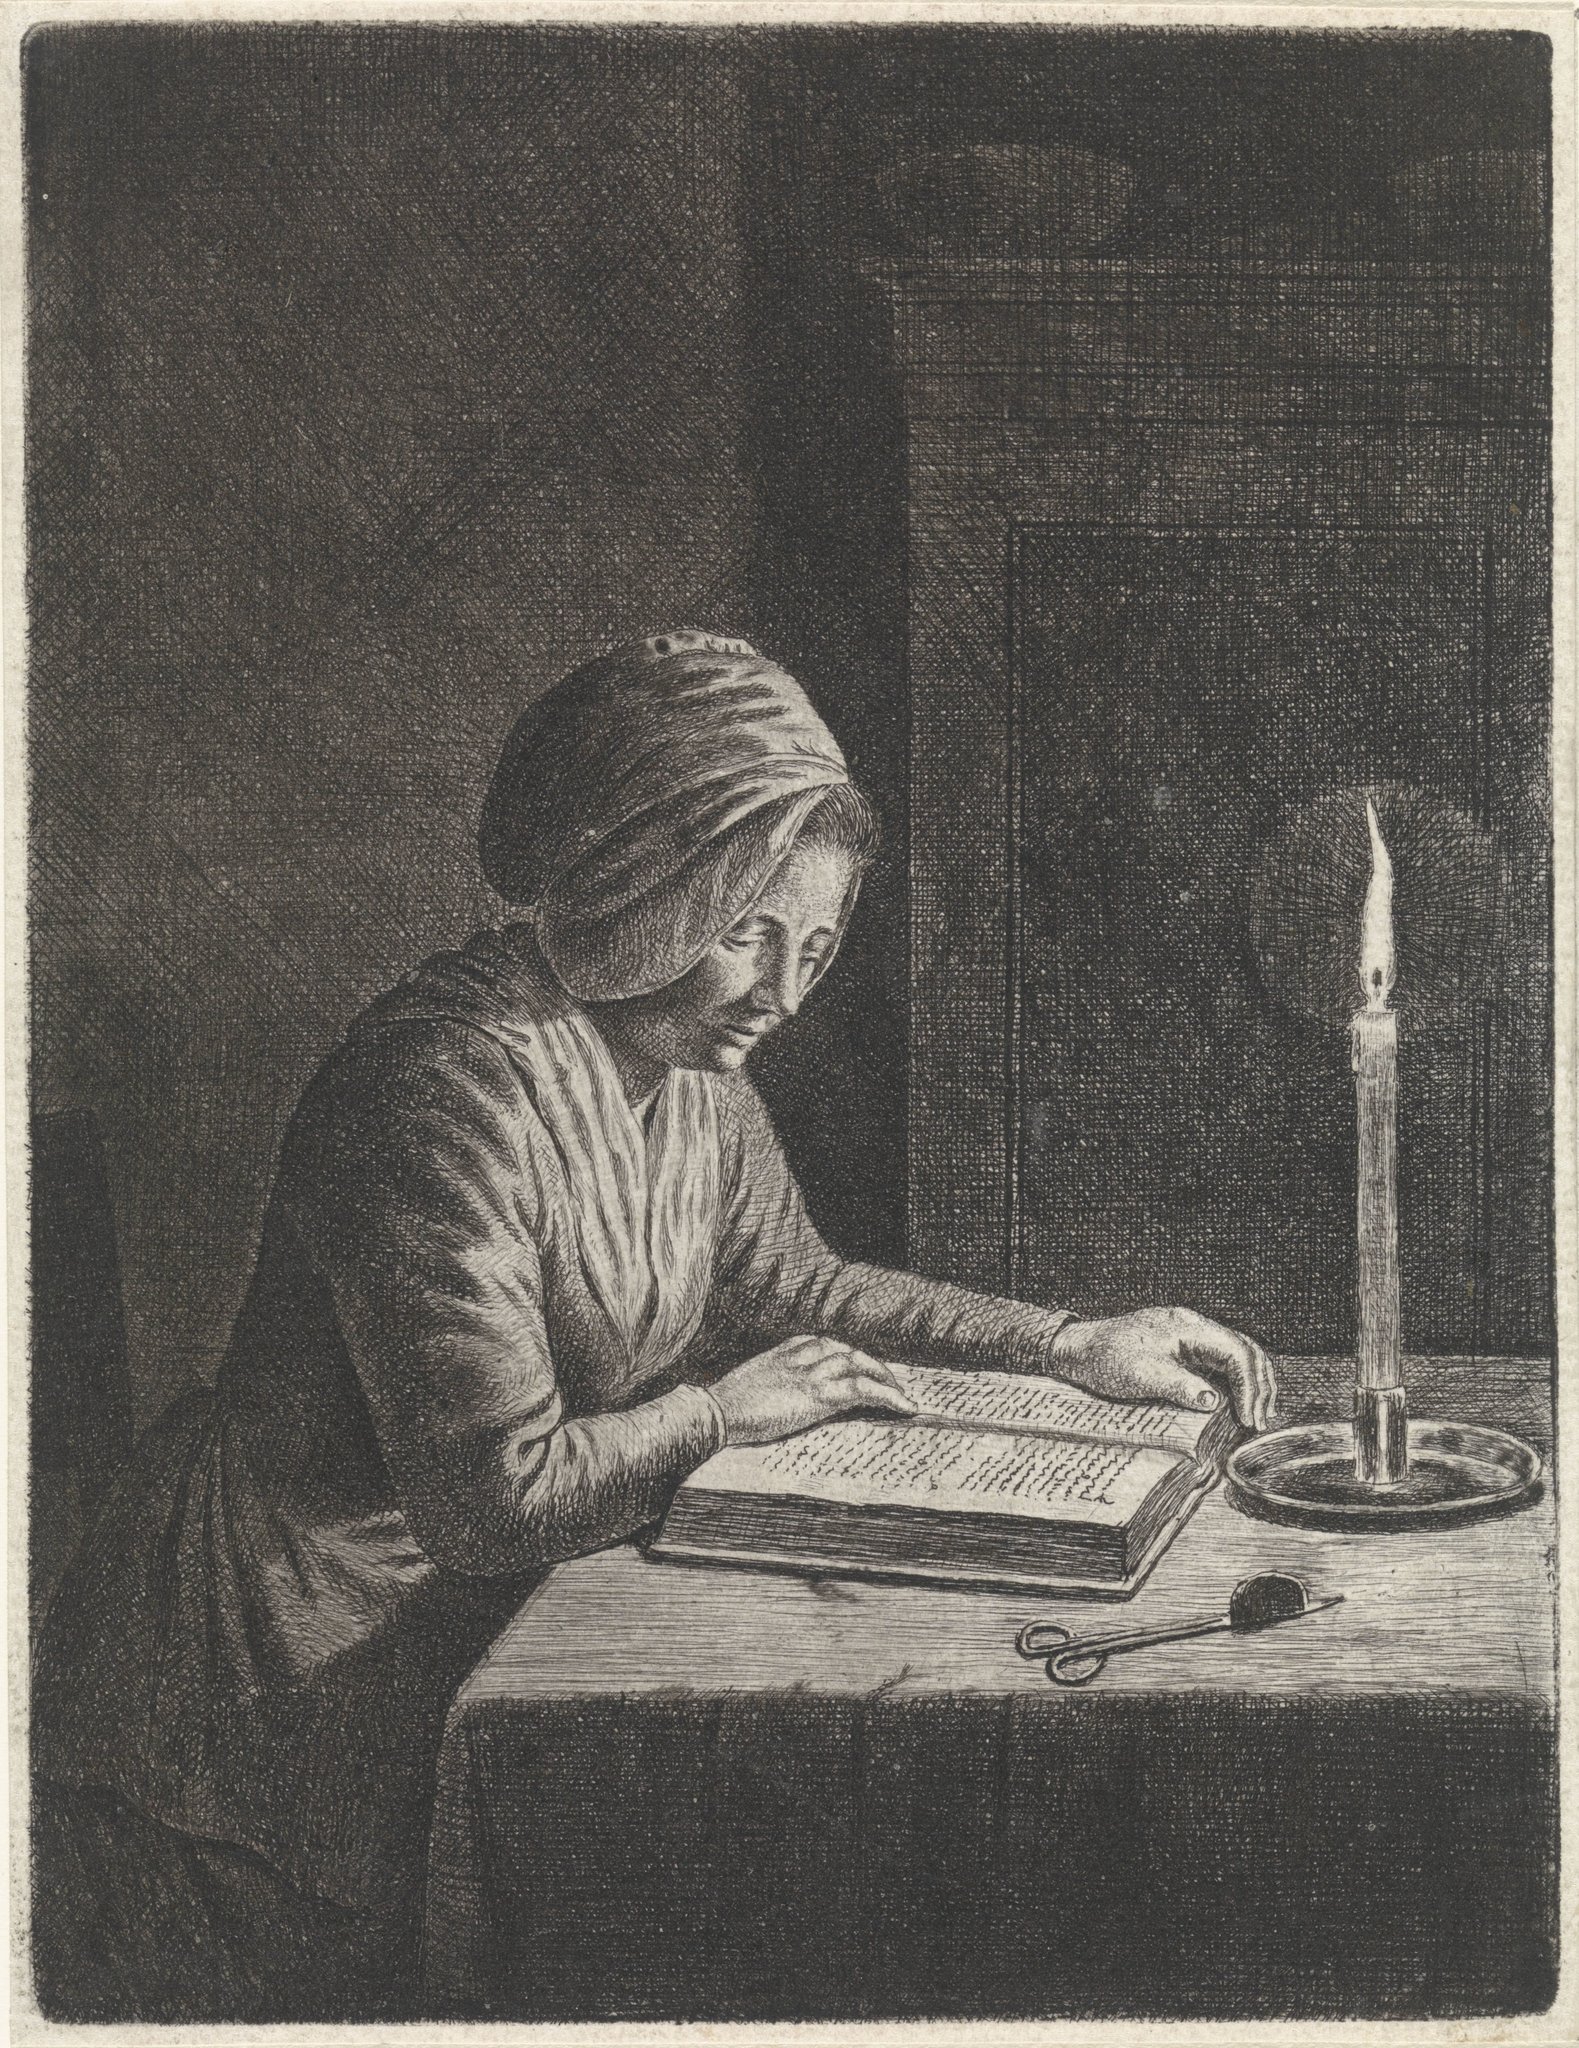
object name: print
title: Donker vertrek met lezende vrouw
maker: johannes christiaan janson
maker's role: draughtsman, painter, print maker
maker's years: 1763-1823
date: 1778-1823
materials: paper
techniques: etching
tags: reading, candle (+ kindling a light; lit, burning light, lamp, candle)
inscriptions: collector's mark: Lugt 2228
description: Donker vertrek met lezende vrouw, zittend aan een tafel. Op de tafel een brandende kaars en een schaar. Op de achtergrond een kast.